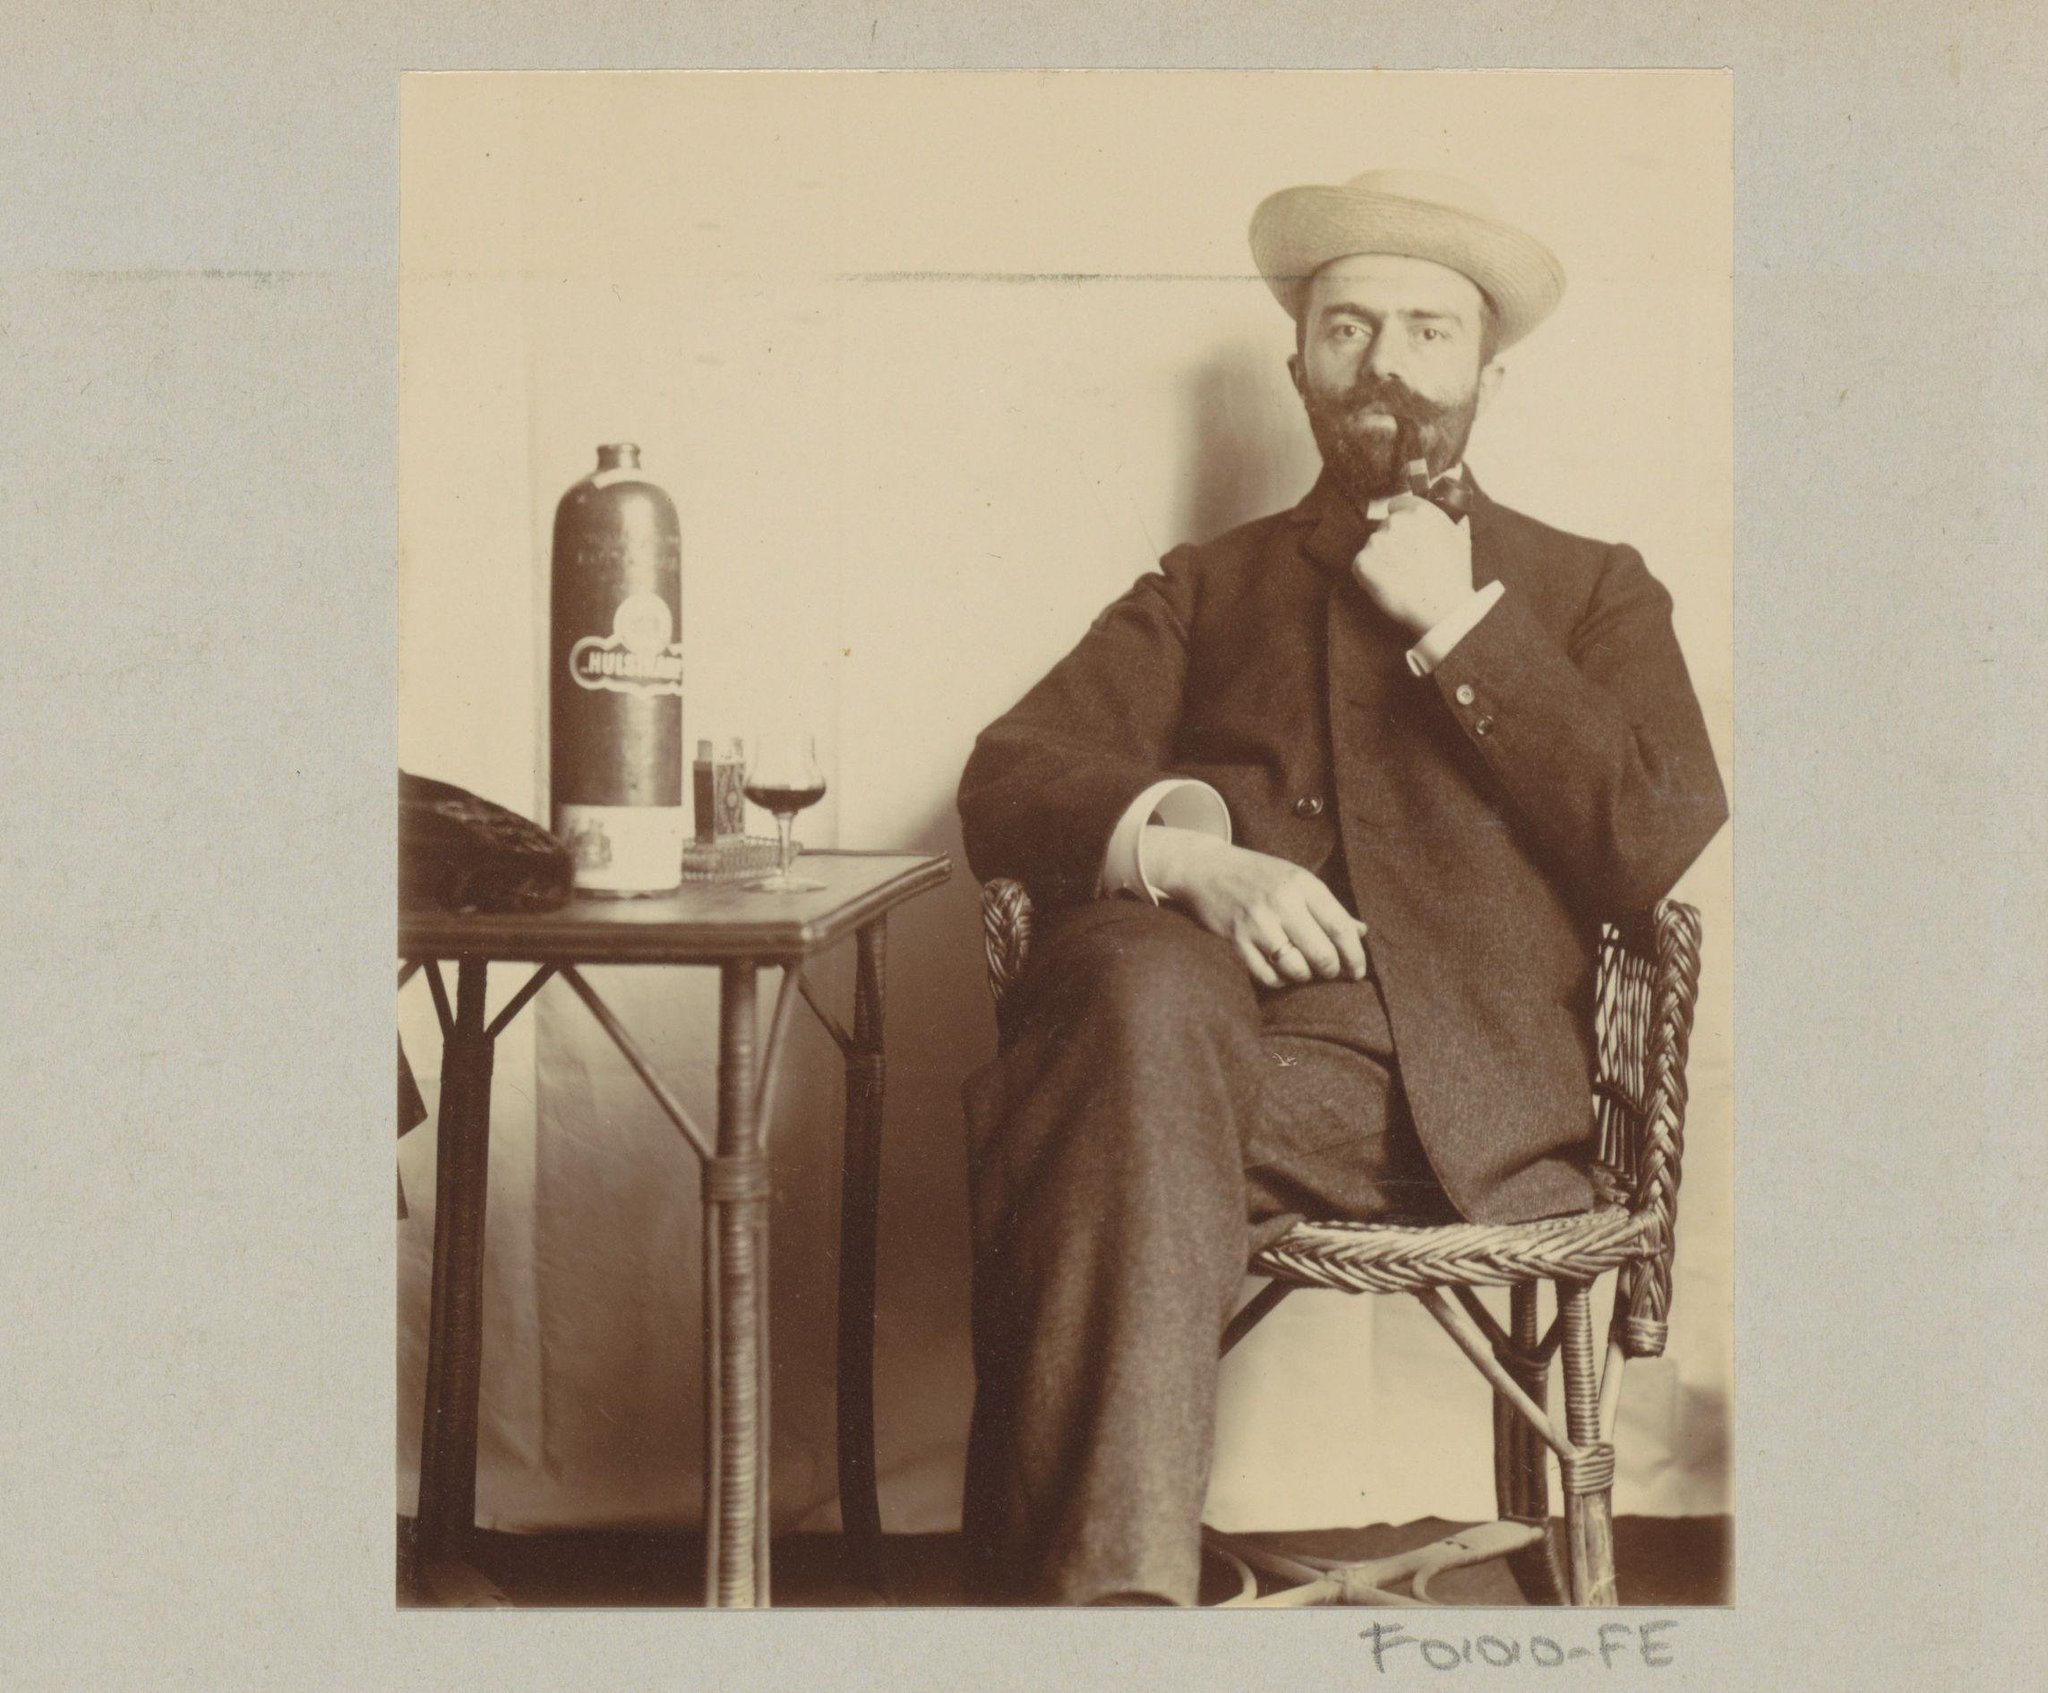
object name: photograph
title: Man met hoed, pijprokend bij een kruik drank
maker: Anonymous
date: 1900-1910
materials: photographic support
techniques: daylight paper print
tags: head-gear, anonymous historical person portrayed alone, pipe ~ tobacco, alcoholic drinks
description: Onderdeel van Familiealbum met onder meer foto's van Wijnhandel Kraaij & Co. Bordeaux-Amsterdam.